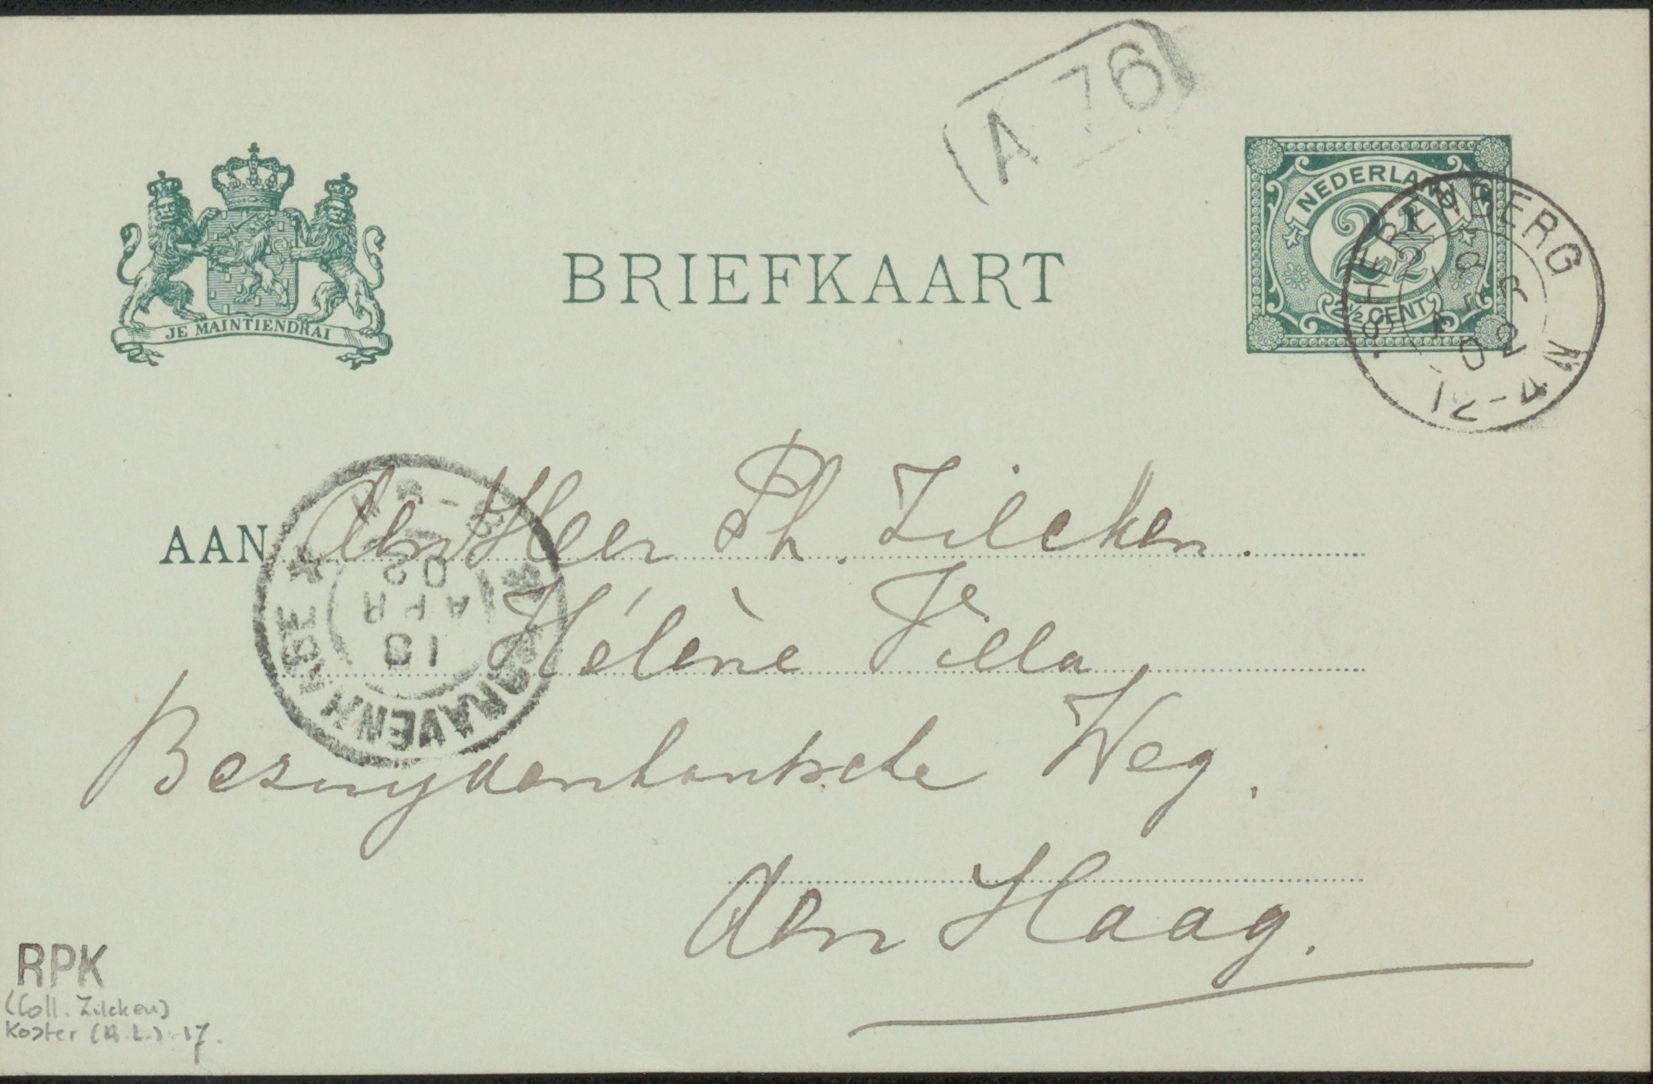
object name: postcard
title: Briefkaart aan Philip Zilcken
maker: anton l. koster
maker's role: draughtsman, painter, print maker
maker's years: 1859-1937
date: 1902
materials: cardboard, ink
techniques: pen, writing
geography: s-heerenberg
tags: publisher, the hague, painter, philip zilcken, the graphic arts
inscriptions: collector's mark: ‘RPK’